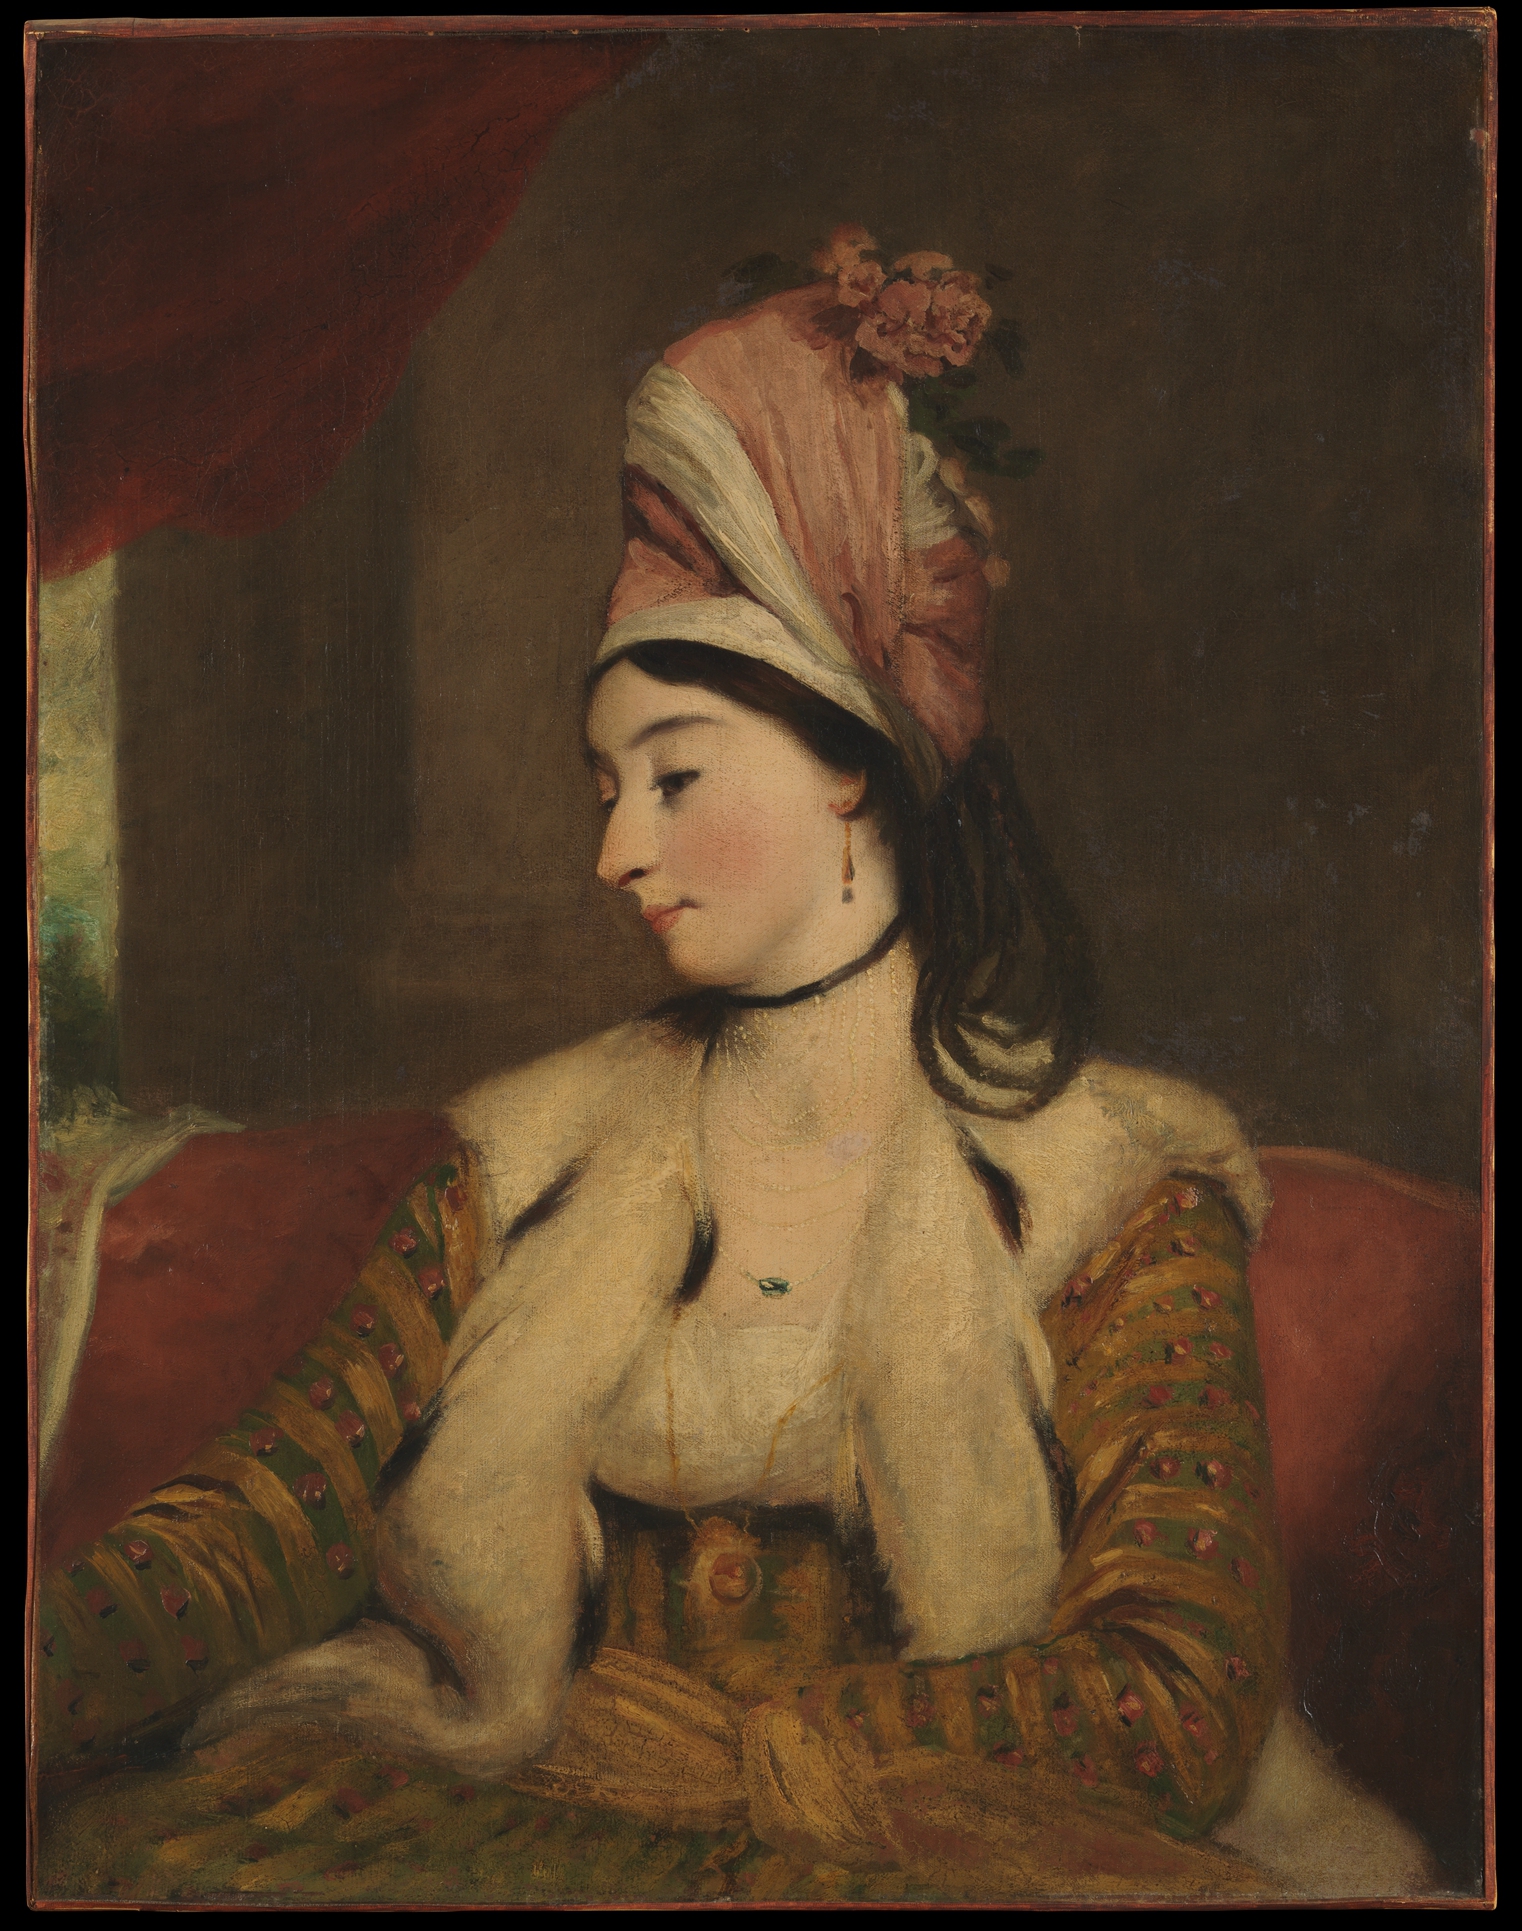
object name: painting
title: Mrs. George Baldwin (Jane Maltass, 1763–1839)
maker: sir joshua reynolds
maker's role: artist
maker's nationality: british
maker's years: 1723-1792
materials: canvas, oil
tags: portraits,women